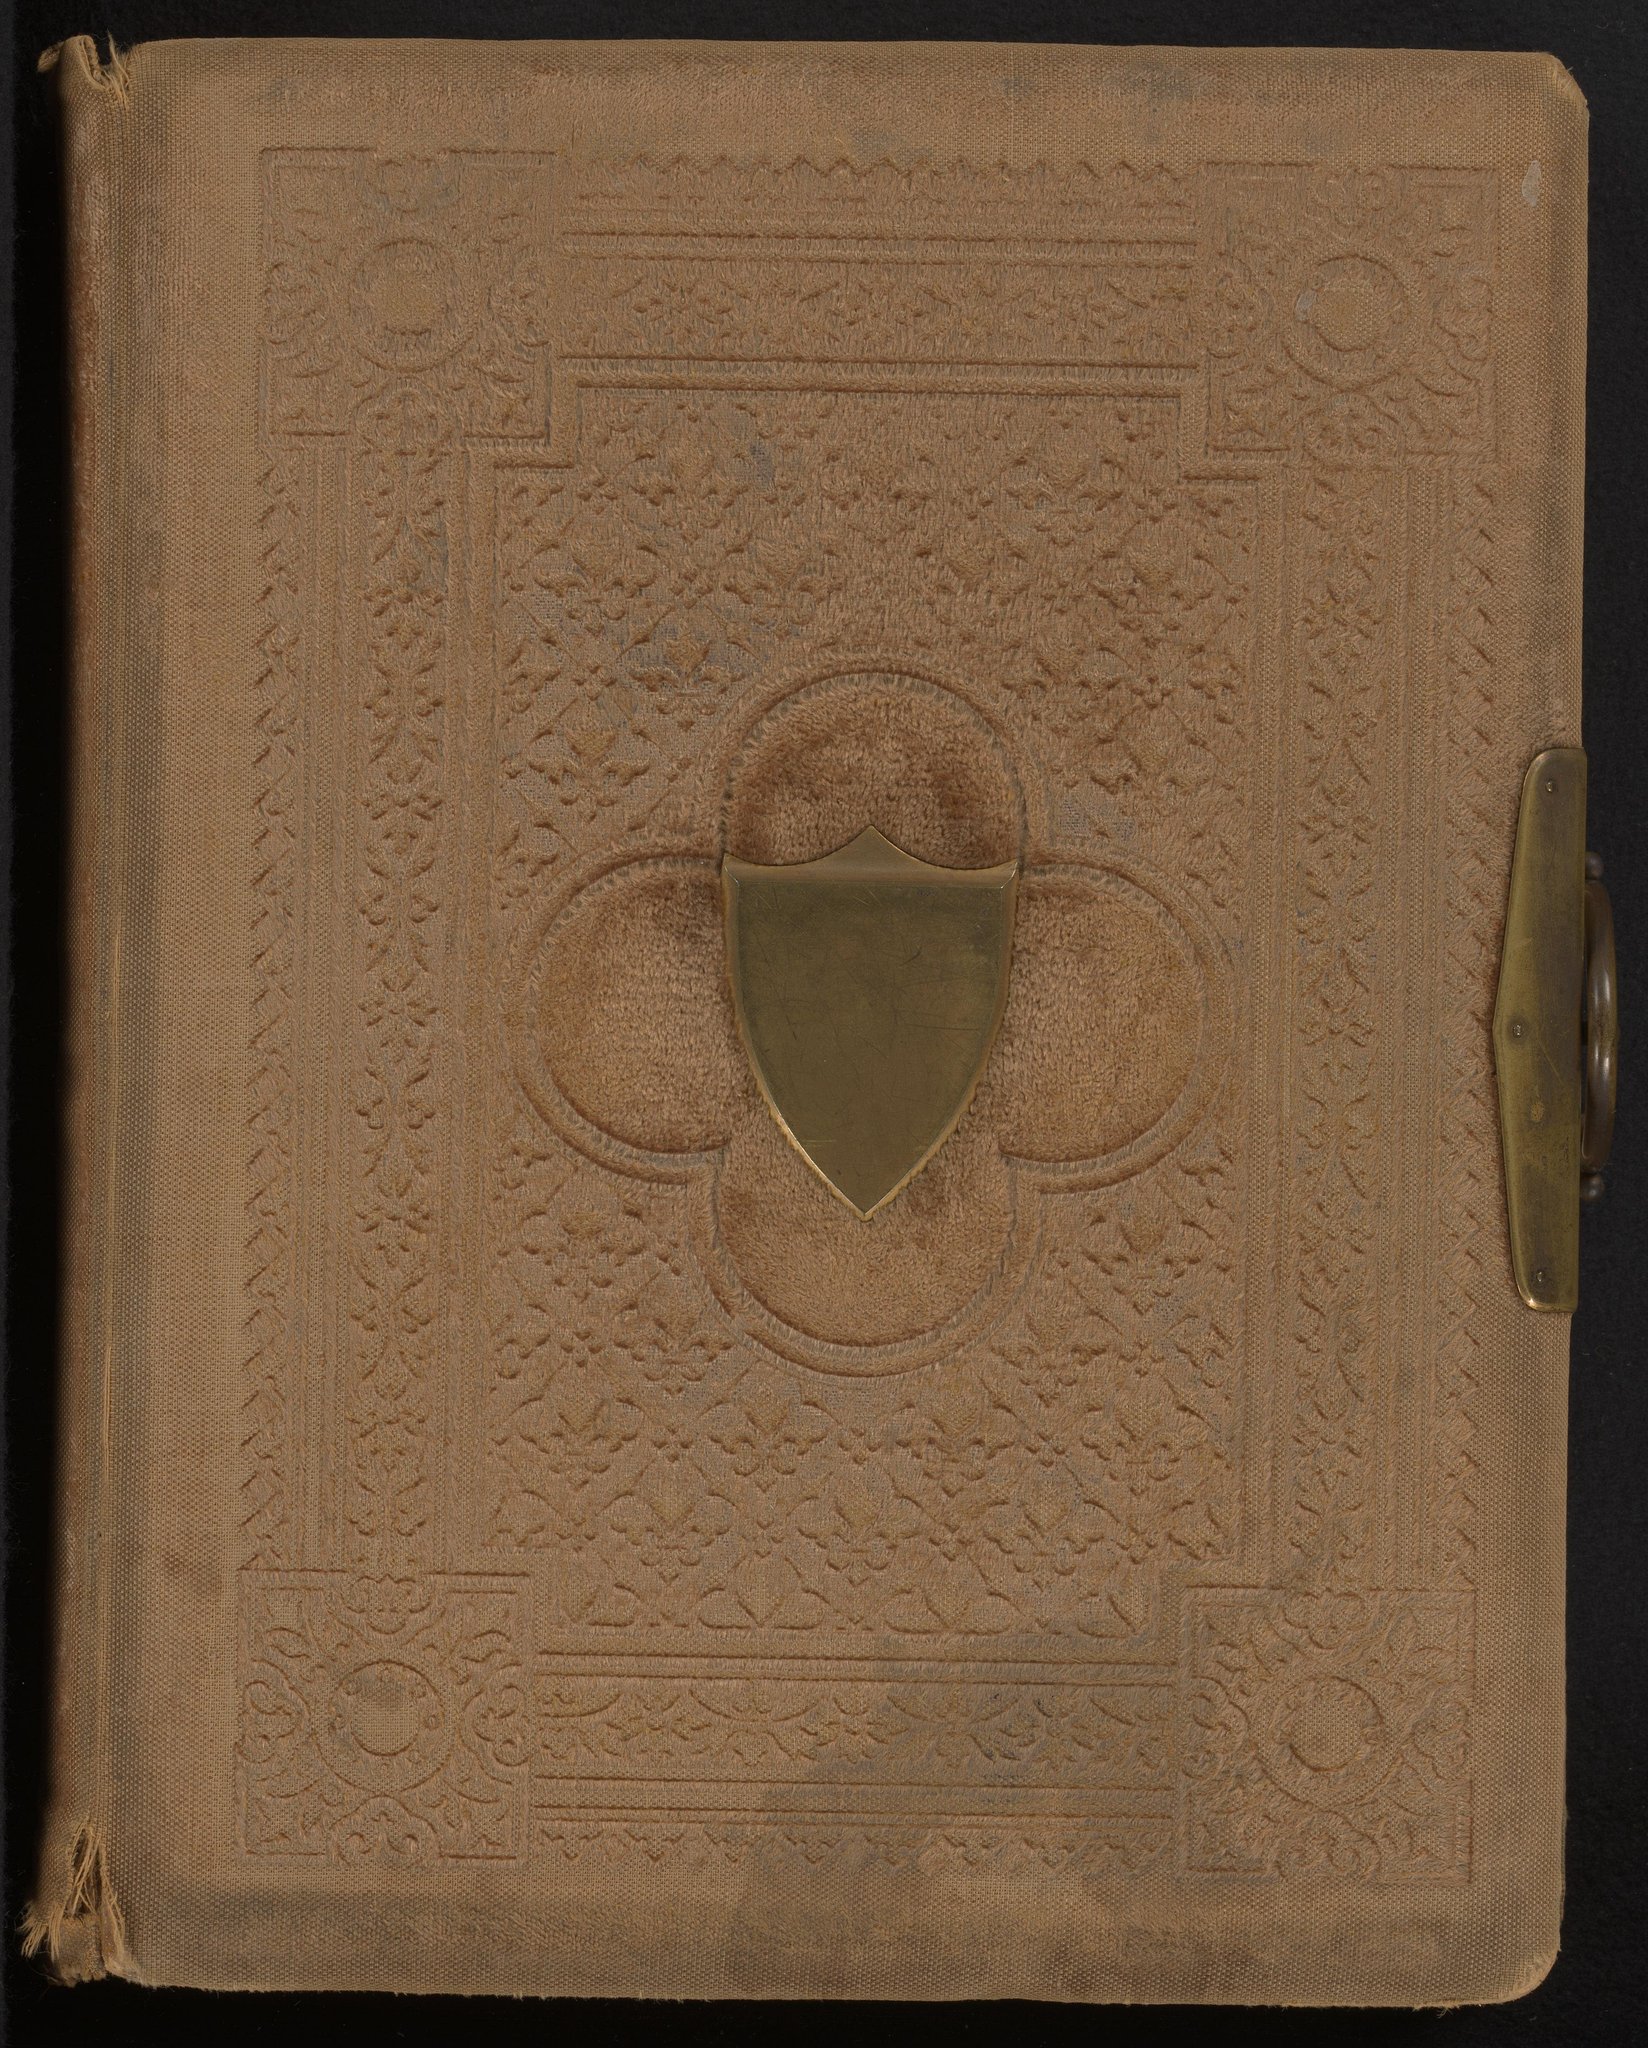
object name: slip in album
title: Fotoalbum van familie Van Braam met 92 foto's, Nederlands en Nederlands-Indië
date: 1865-1875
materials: cardboard, linen, metal, paper, photographic support, textile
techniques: albumen print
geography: batavia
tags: willem van braam, arnhem, charlotte catharina van braam, historical persons - bb - woman, boy (child between toddler and youth), historical persons, anonymous historical persons portrayed in a group, in a group-portrait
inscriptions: collector's mark: ‘Dienst Verspreide Rijkskollekties (...) A 664’, number: ‘25,-’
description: Fotoalbum met 92 foto's op 20 bladen met insteekpasse-partouts op zowel carte-de-visite als kabinetkaart-formaat samengesteld door familie Van Braam. Het zijn allemaal portretten vervaardigd door onder andere Woodbury & Page, Carel Eduard Westerborg, J.B. Jasper en anderen. Het eerste portret is van Loty van Braam en in sommige opschriften worden namen van neven en nichten vermeld.